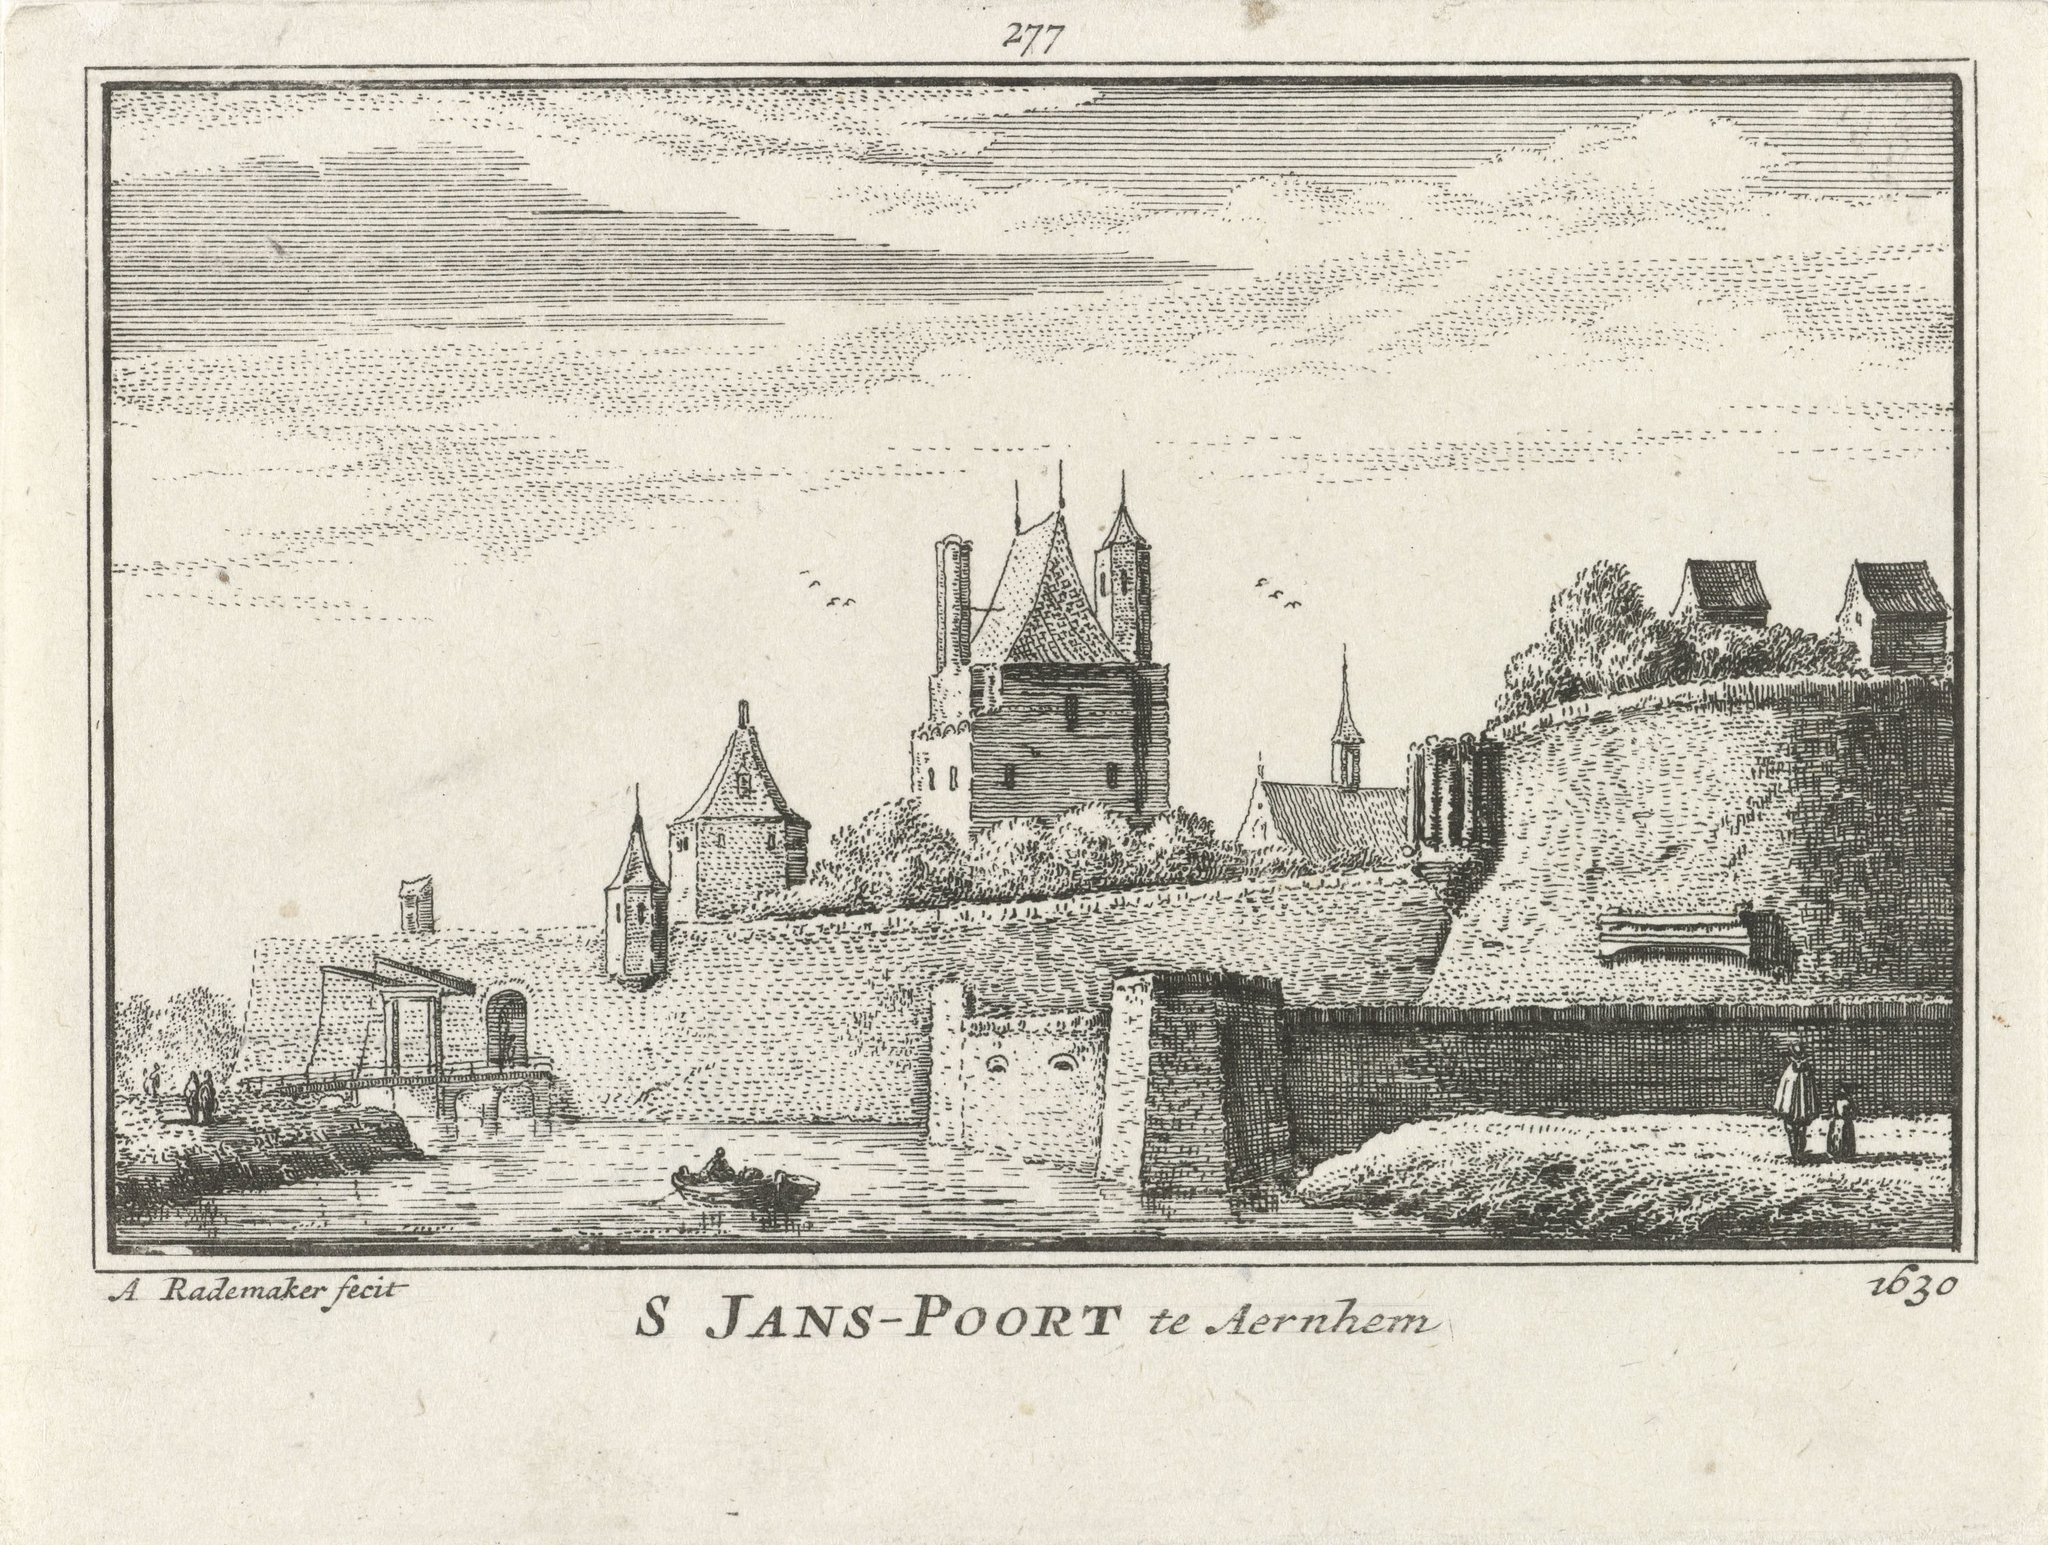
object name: book illustration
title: S Jans-Poort te Aernhem 1630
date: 1727-1733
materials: paper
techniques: etching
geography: amsterdam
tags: rowing-boat, canoe, etc.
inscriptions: collector's mark: Lugt 2228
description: Illustratie uit: Abraham Rademaker, Matthaeus Brouërius van Niedek, Isaac Le Long, Kabinet van Nederlandsche en Kleefsche outheden en (...) voorname stads- en landgebouwen, Willem Barents en Antoni Schoonenburg: Amsterdam, 1727-1733, ill. nr. 277.